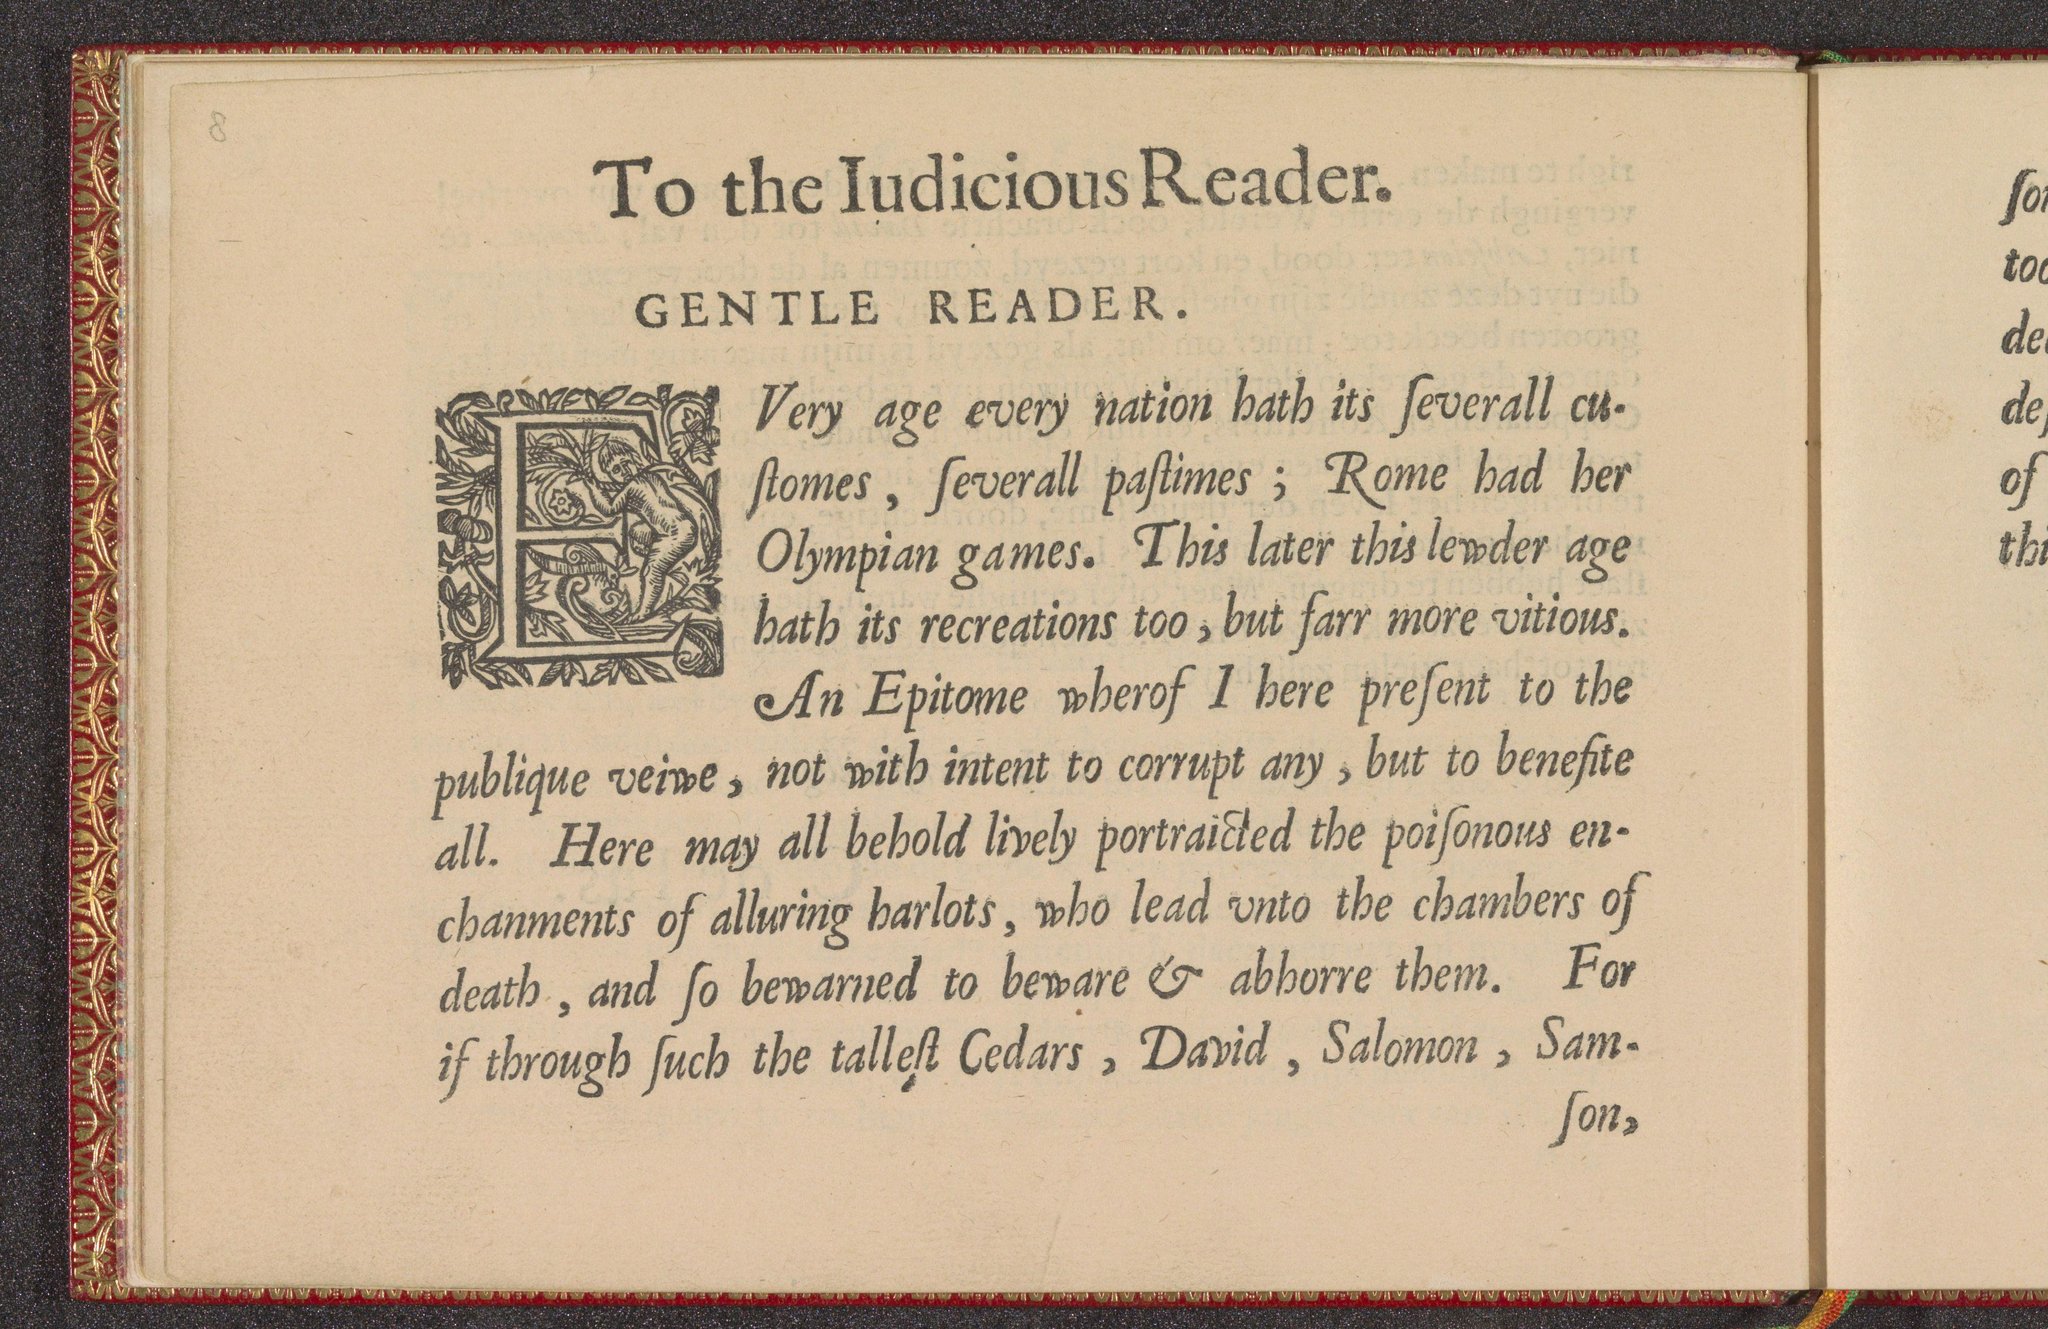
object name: album leaf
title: Les abus du mariage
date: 1641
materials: paper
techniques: letterpress printing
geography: amsterdam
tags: initial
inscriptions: date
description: Engelstalig voorwoord op twee pagina's: pagina 1. Met de aanhef: To the judicious reader. De tekst vangt aan met een gedecoreerde initiaal E. Het blad maakt deel uit van een album.